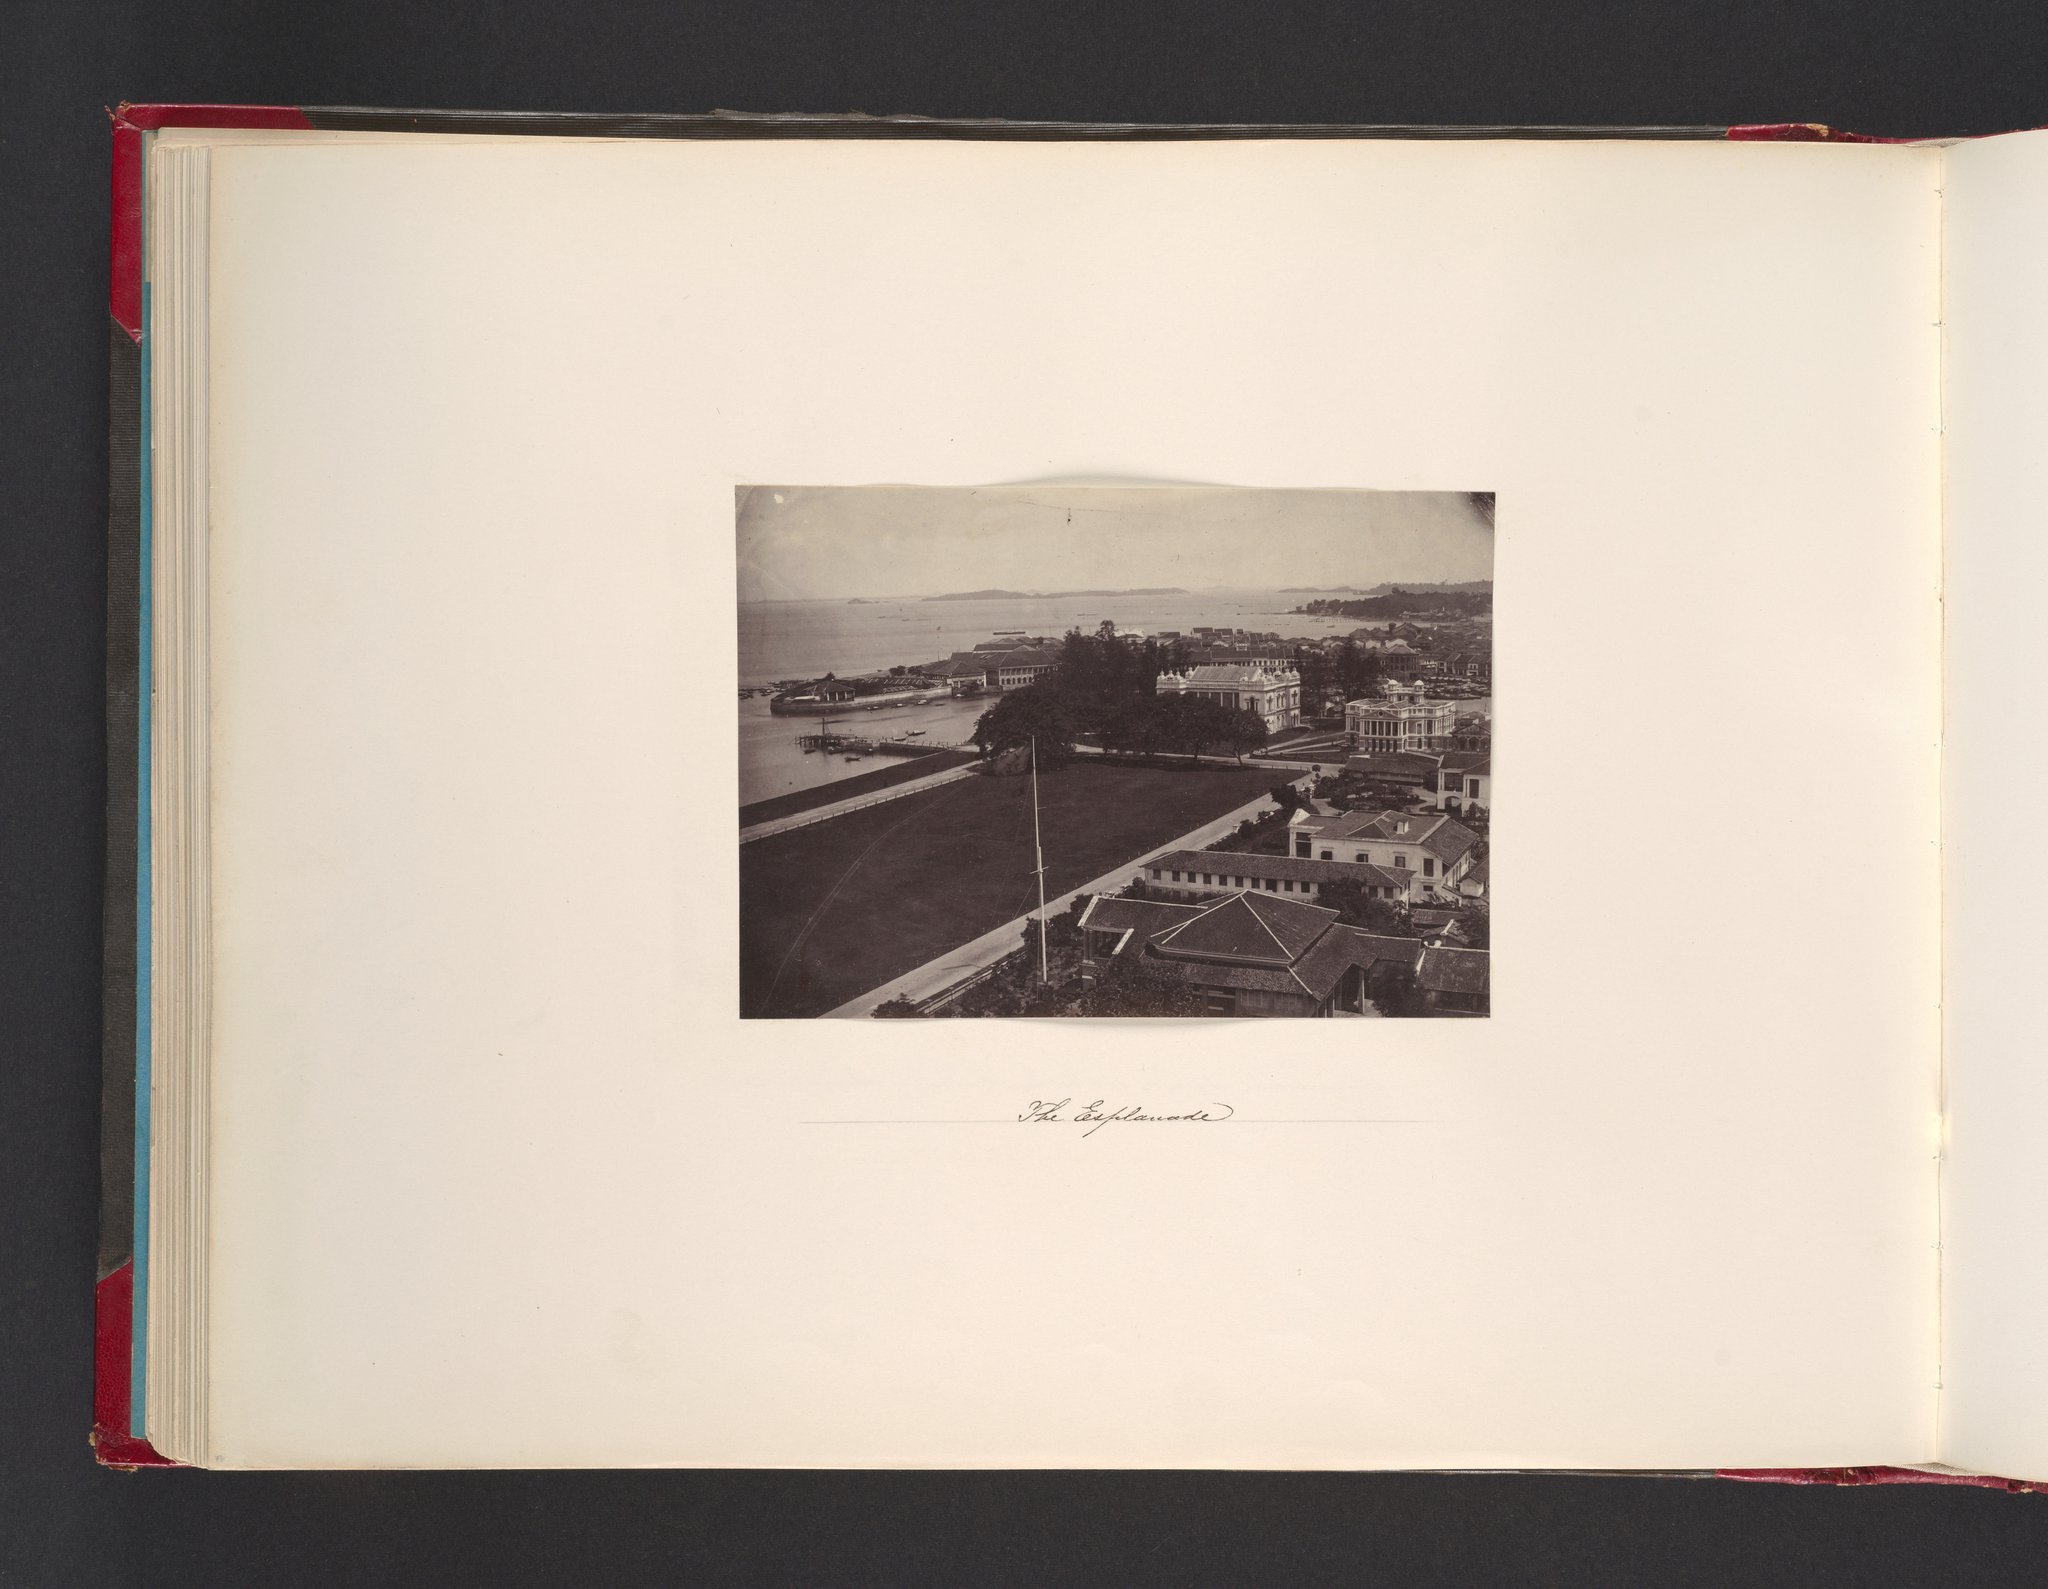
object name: photograph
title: The Esplanade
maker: john thomson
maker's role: artist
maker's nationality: british, scottish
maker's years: 1837-1921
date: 1865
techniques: albumen silver print, glass negative